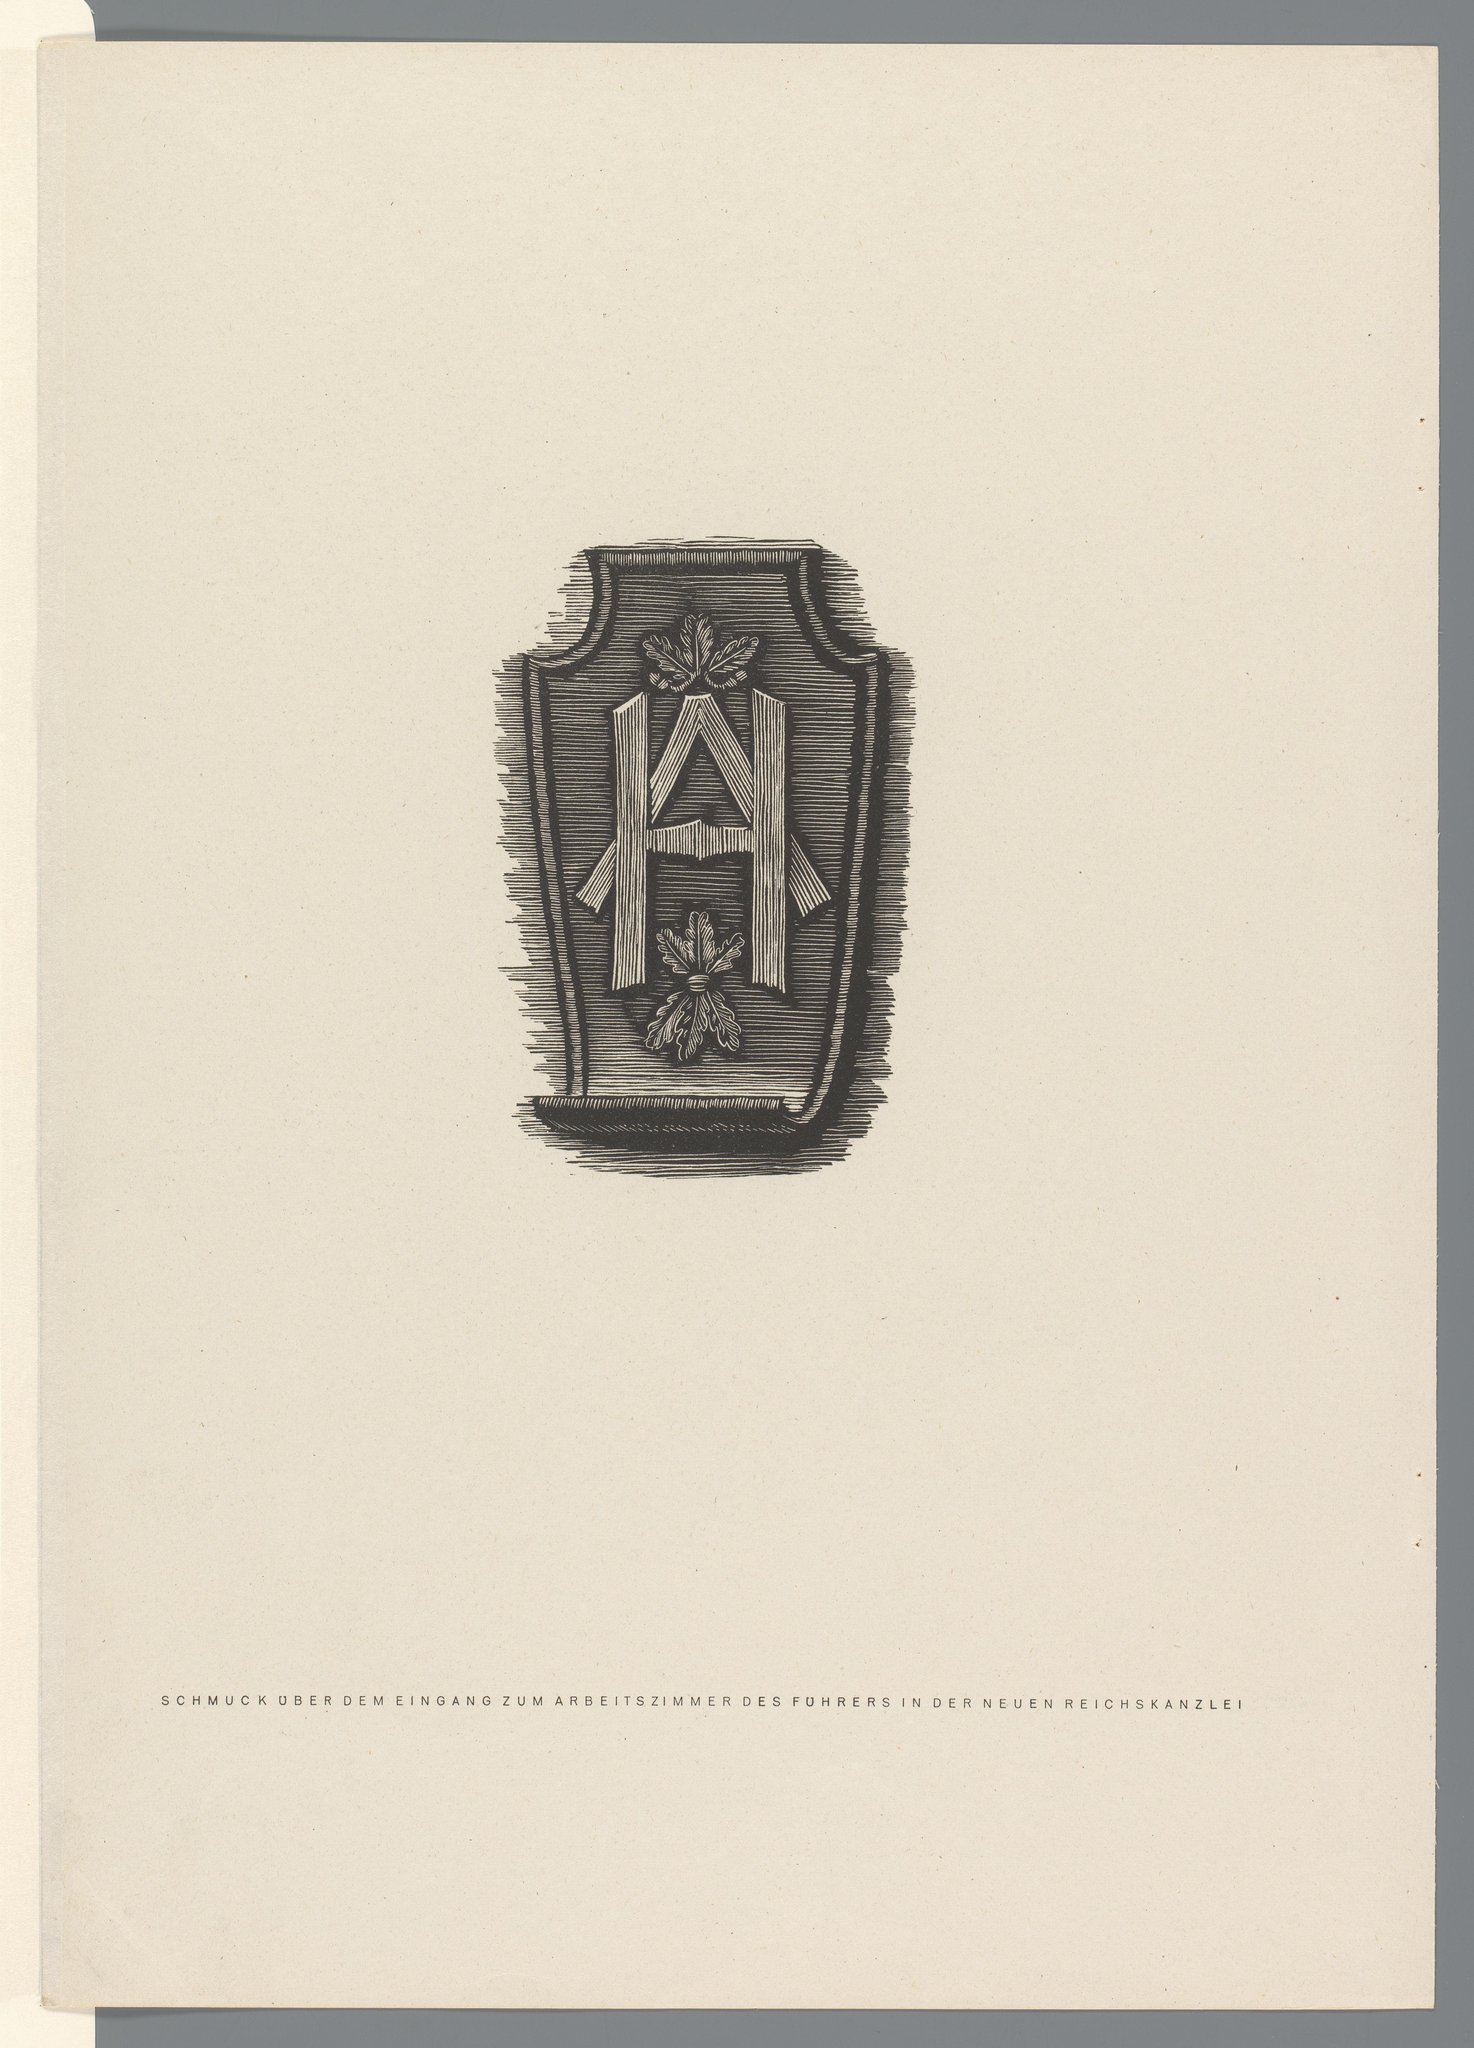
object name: print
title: Monogram van Adolf Hitler in zijn werkkamer in de Rijkskanselarij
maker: karl mahr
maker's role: houtgraveur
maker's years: 1890-1945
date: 1942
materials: paper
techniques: letterpress printing, engraving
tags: berlin, politician, adolf hitler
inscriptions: date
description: Prent uit het Weihnachtsnummer van: Illustrirte Zeitung 100 (1942).